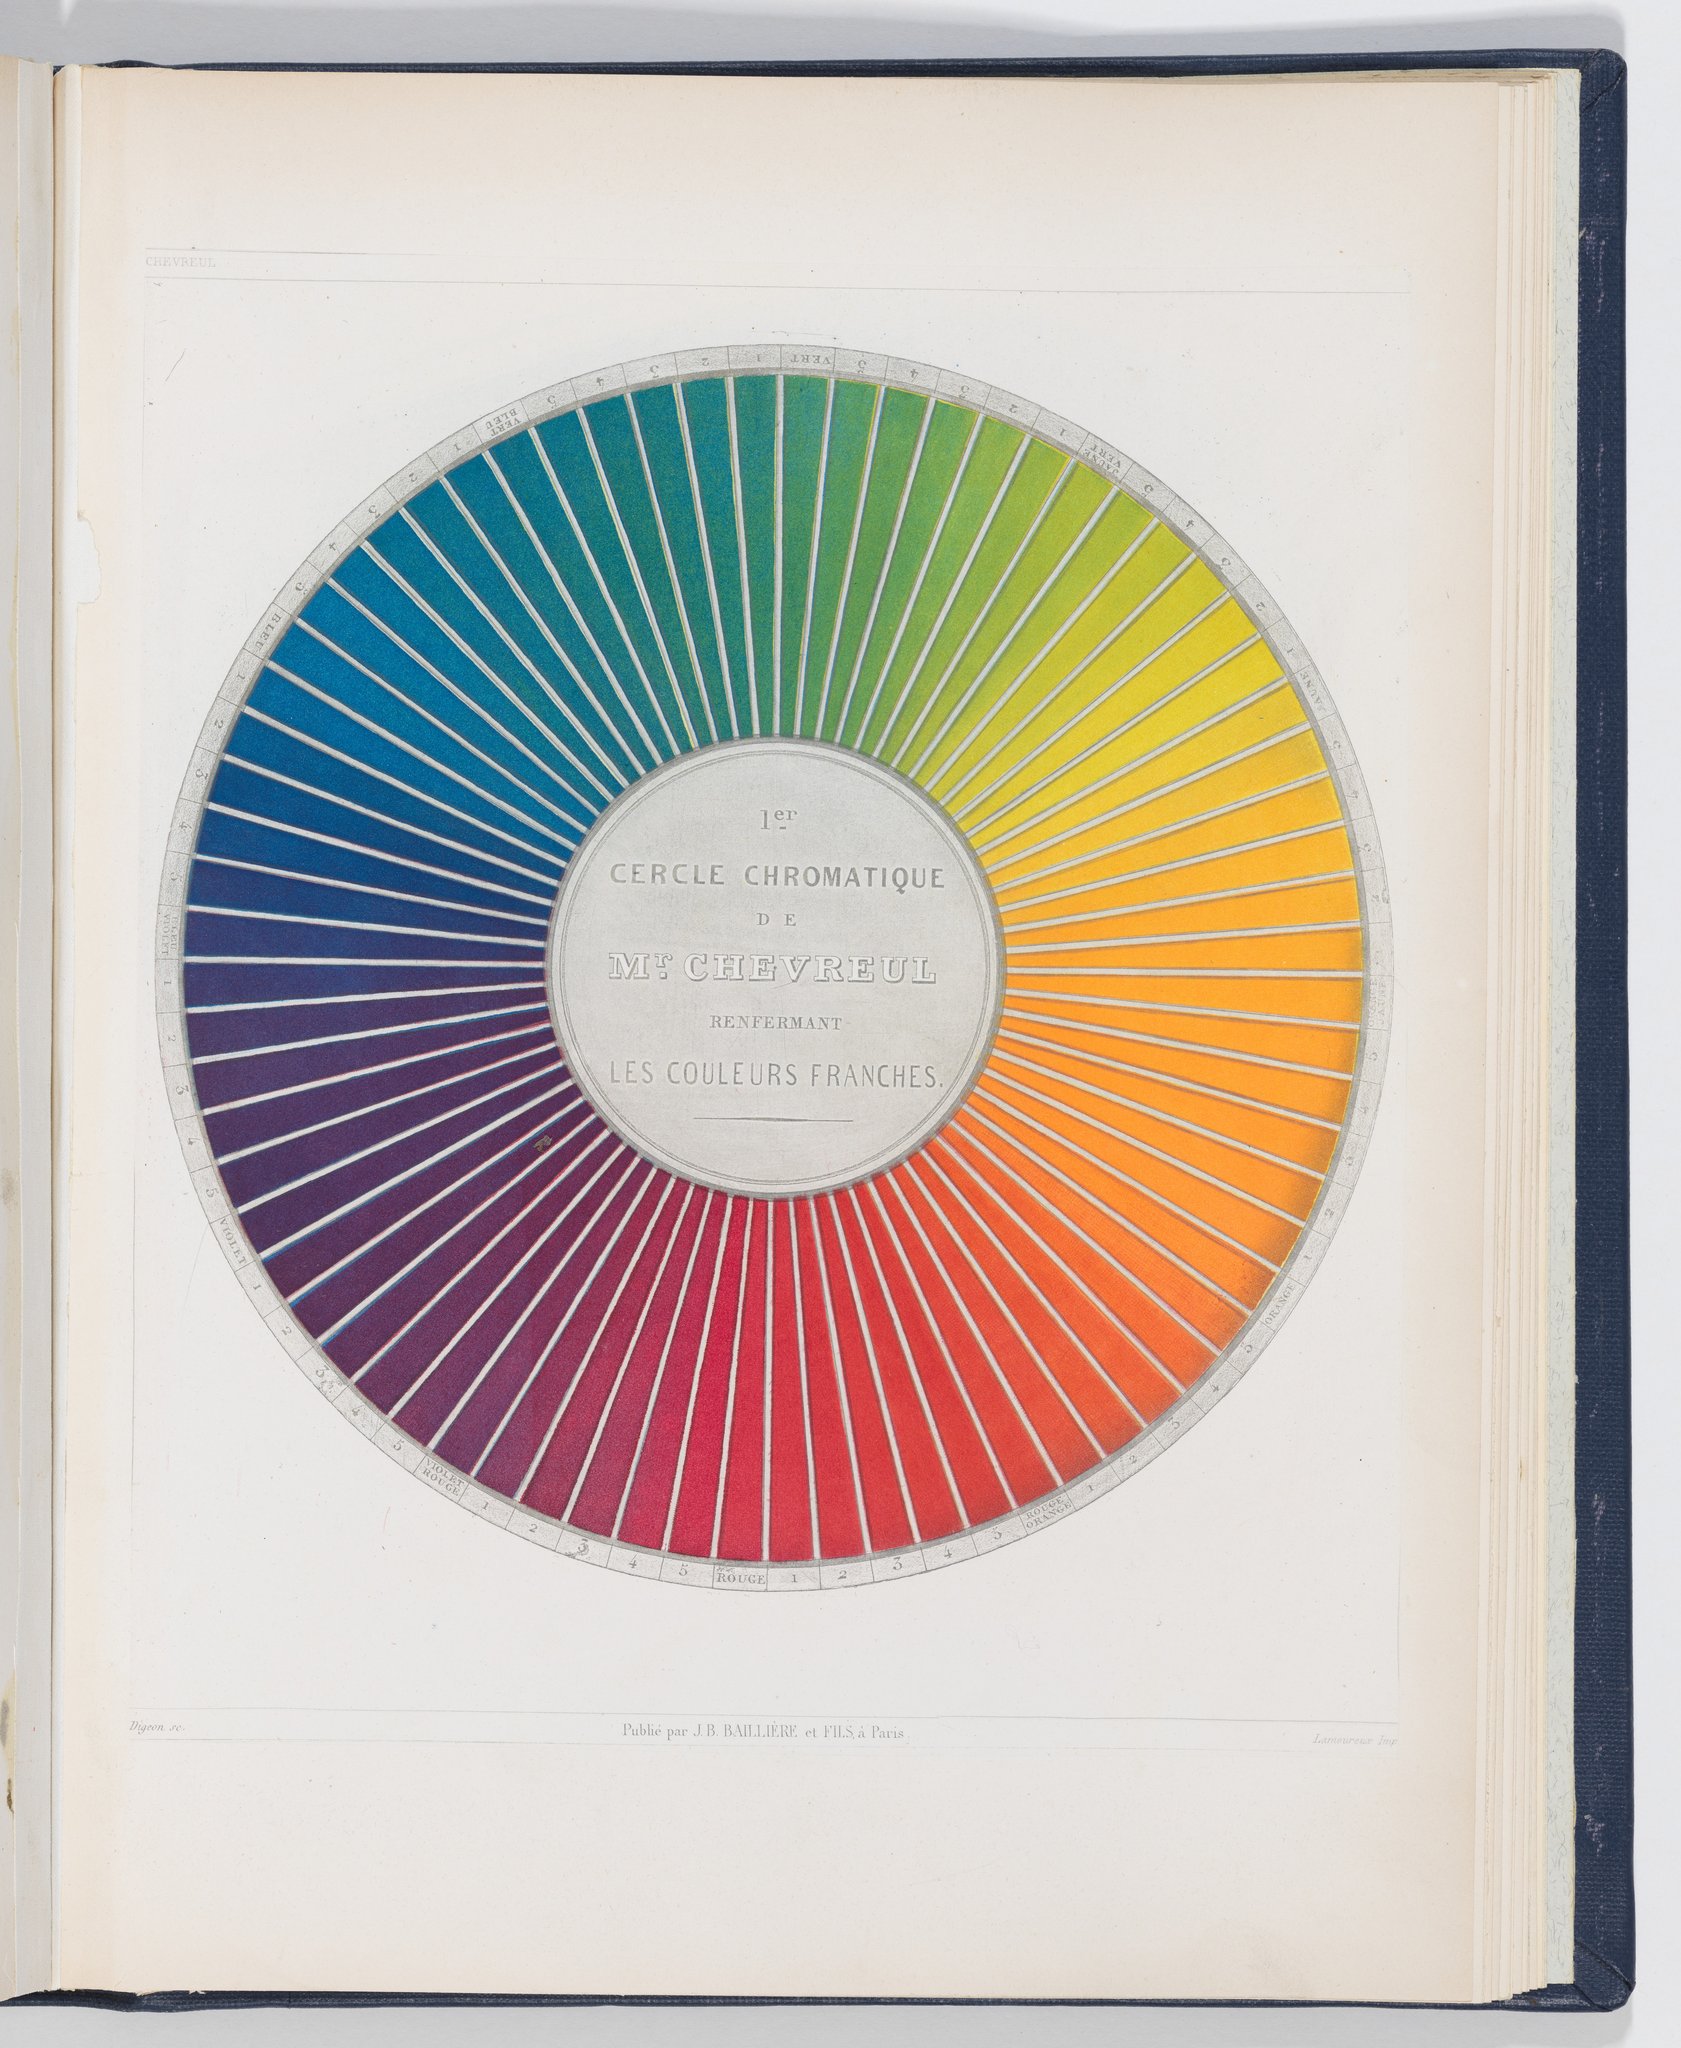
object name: book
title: Des Couleurs et de leurs Applications aux Arts Industriels à l'Aide de Cercles Chromatiques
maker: michel eugène chevreul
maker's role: author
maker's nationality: french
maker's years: 1786-1889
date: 1864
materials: steel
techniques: engraving, printing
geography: france